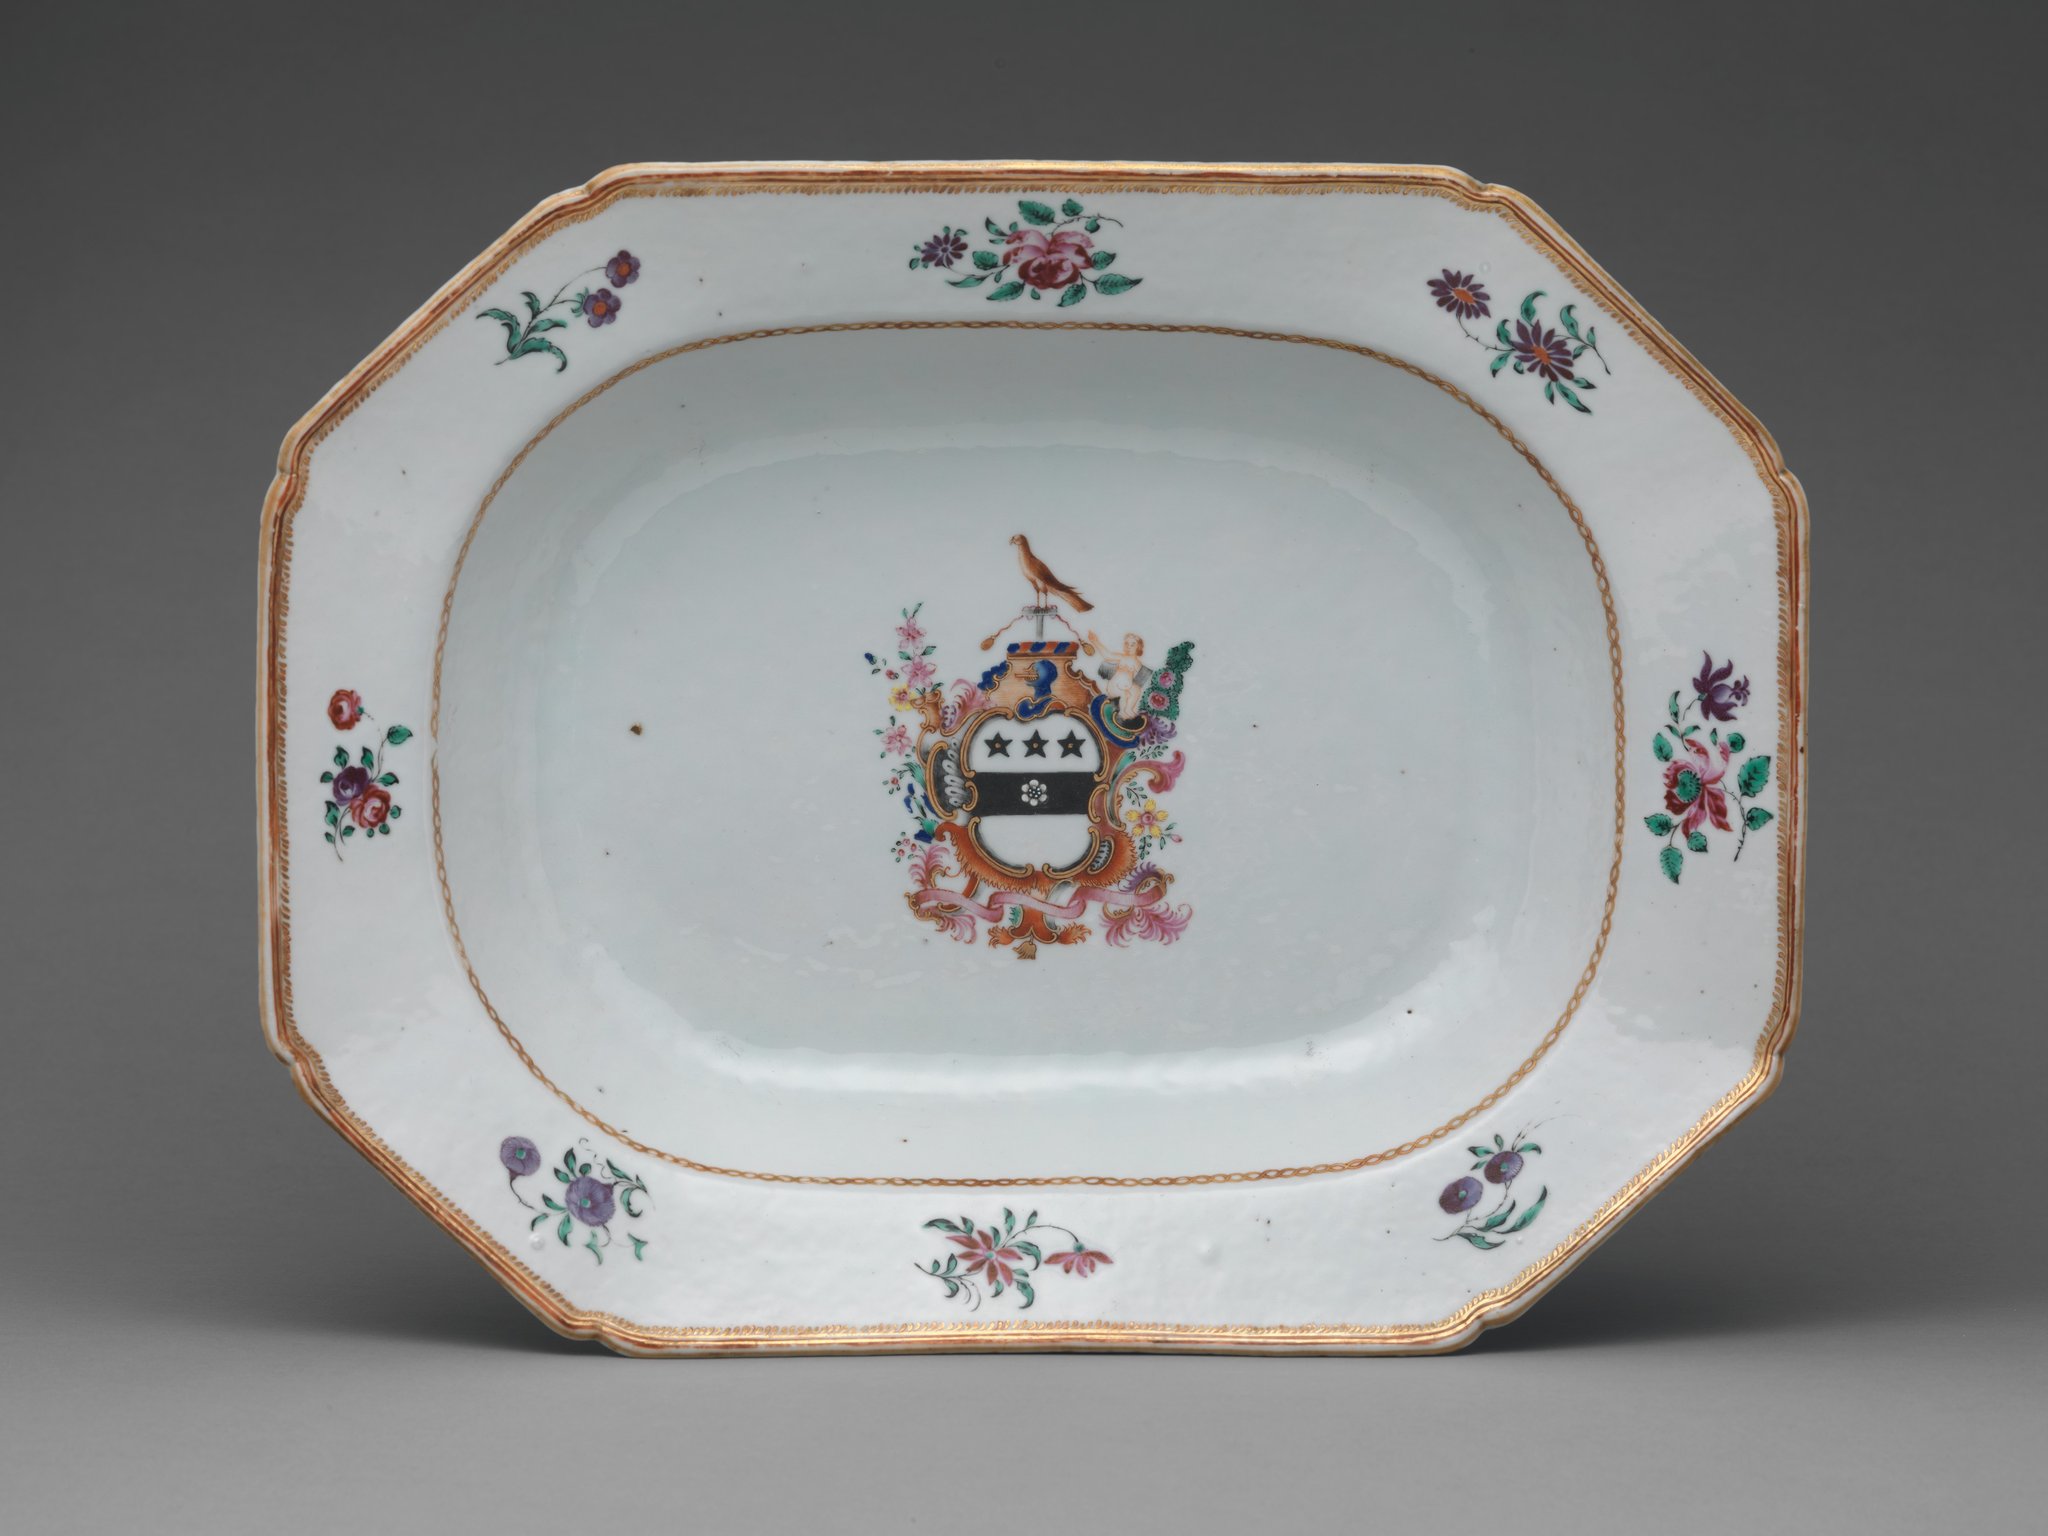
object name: platter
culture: chinese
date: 1785-1790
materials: porcelain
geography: china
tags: birds,flowers,coat of arms